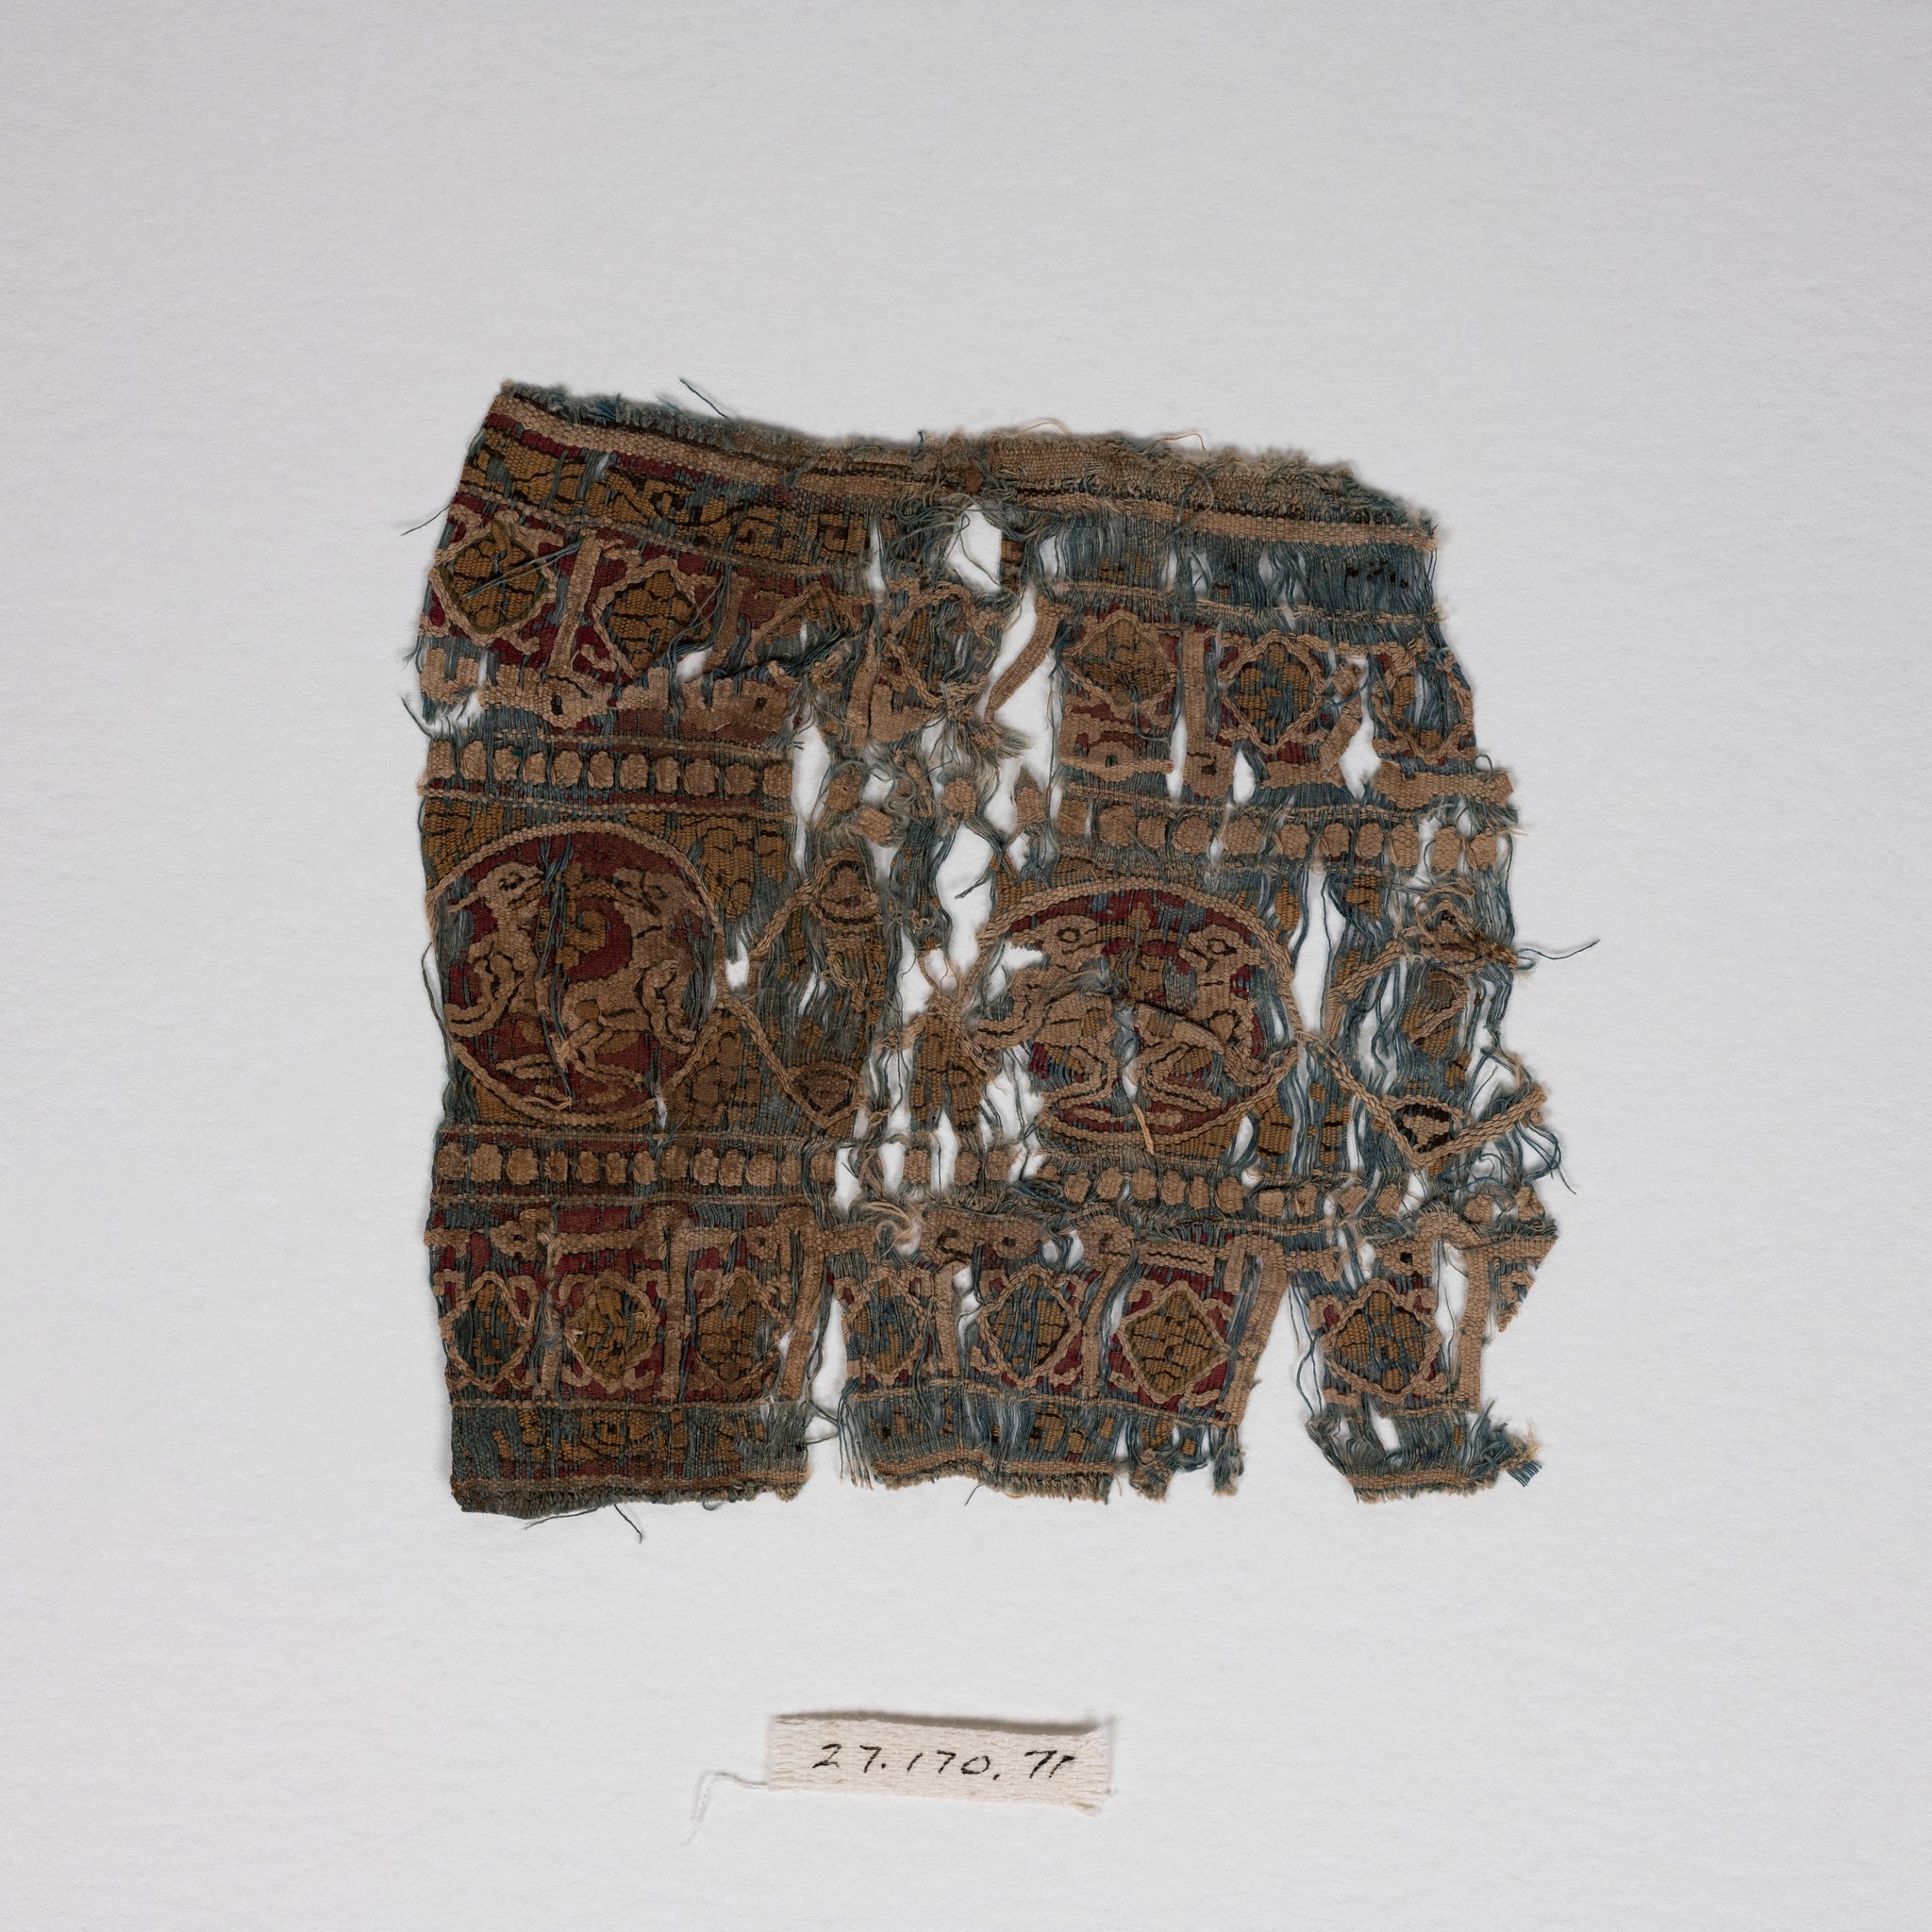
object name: textile fragment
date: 1001-1100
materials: linen, silk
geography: egypt